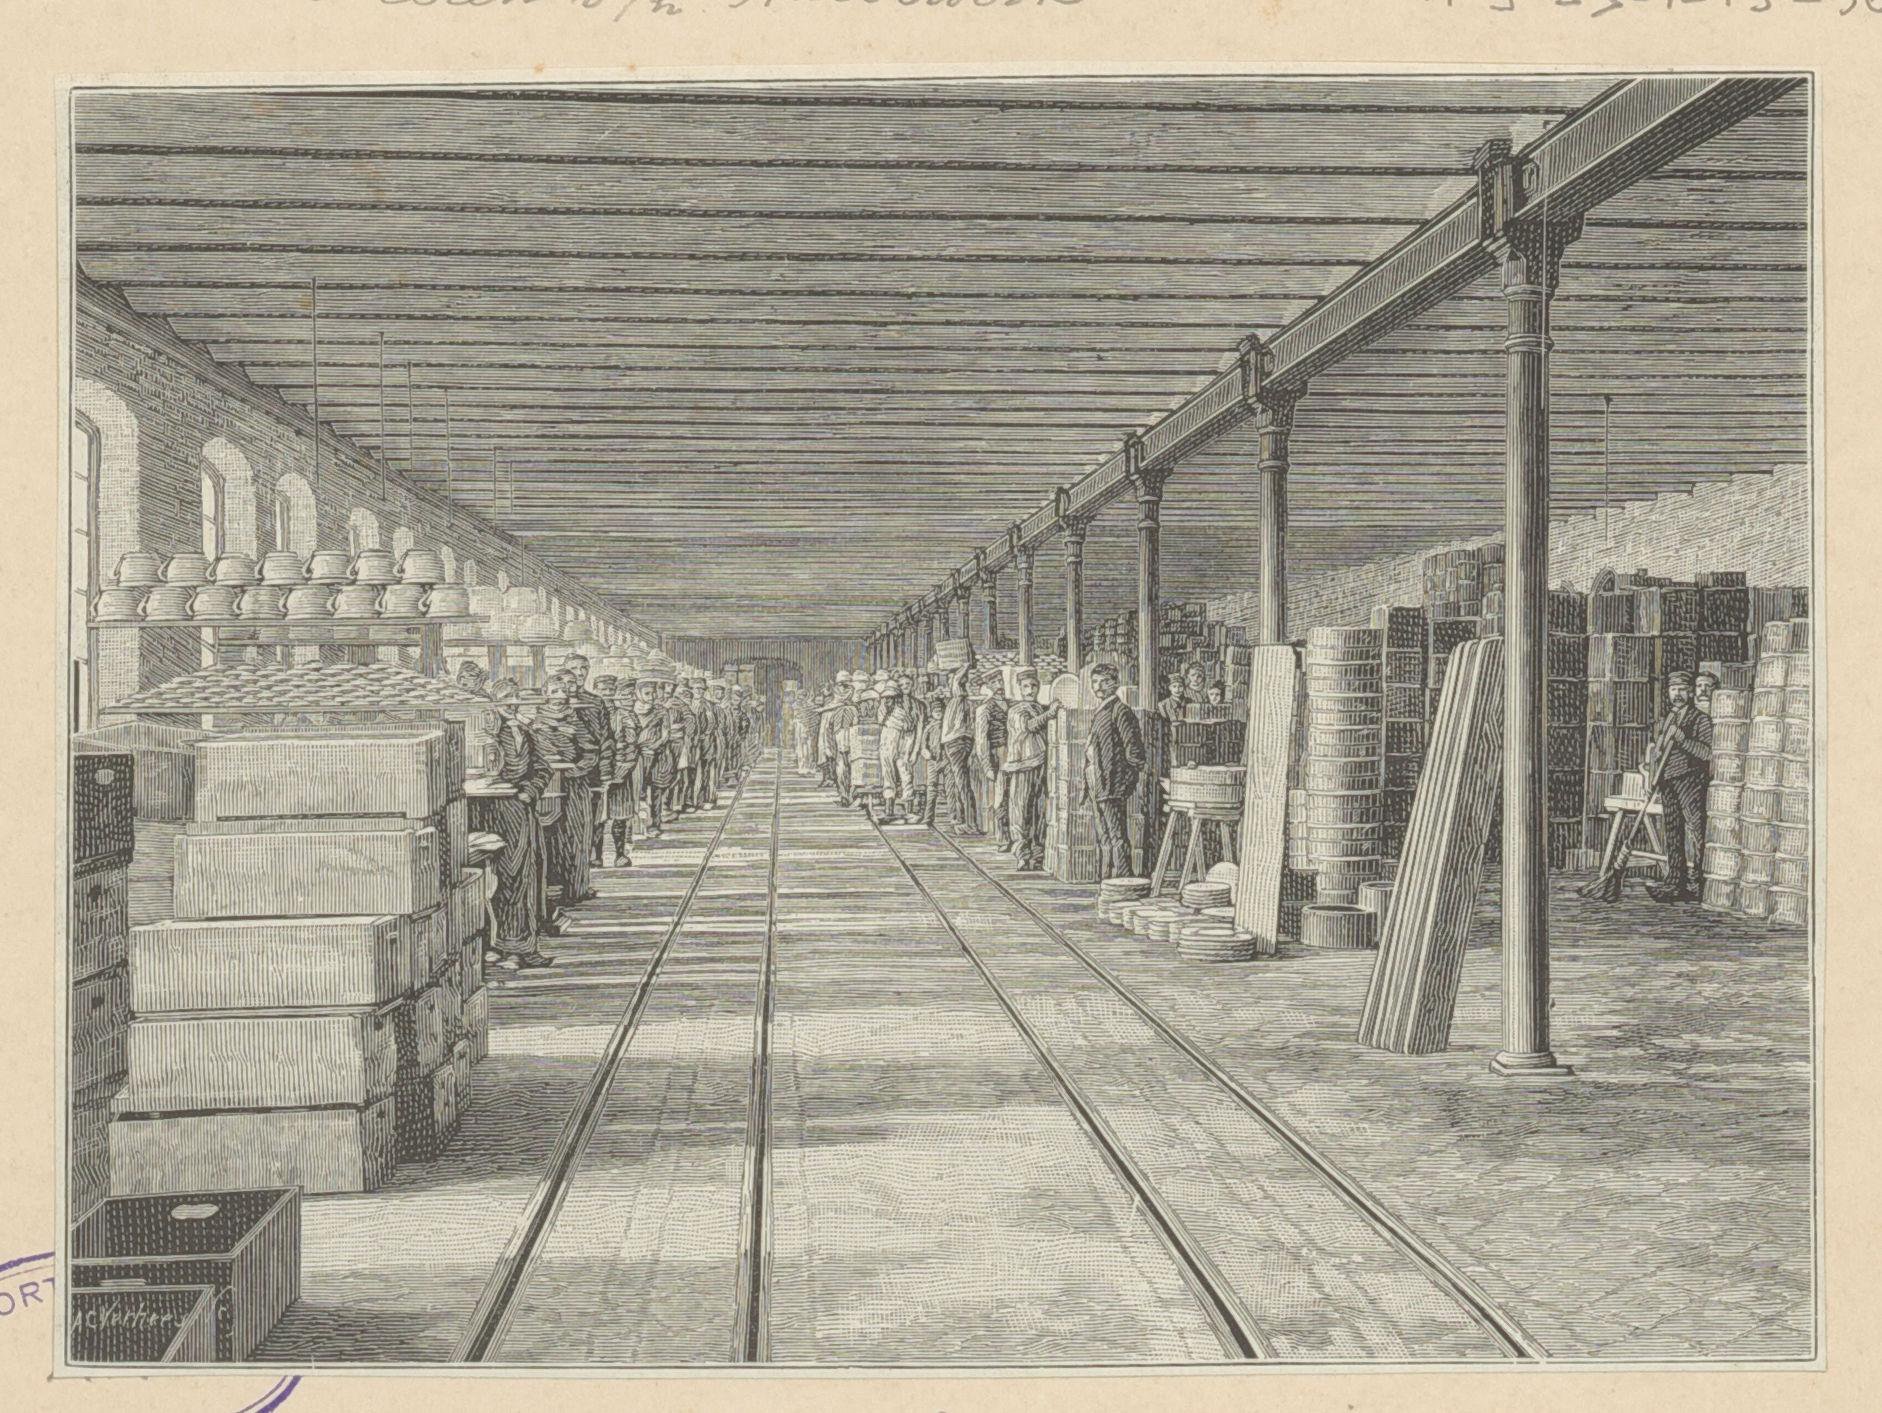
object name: print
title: Sorteren van het aardewerk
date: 1887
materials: paper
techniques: letterpress printing, engraving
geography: haarlem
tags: handicrafts, craftsman at work, factory-building, handicrafts ~ clay, sand, chalk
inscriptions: stamp, stamp, collector's mark: Lugt 1641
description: Sorteren van het aardewerk in Sociétè Céramique. Onderwerpsrubrieken binnen de Atlas Zeden en Gewoonten: Handel, Nijverheid en verkeer, Beroep en bedrijf, Mannelijk, Glas en Aardewerk.